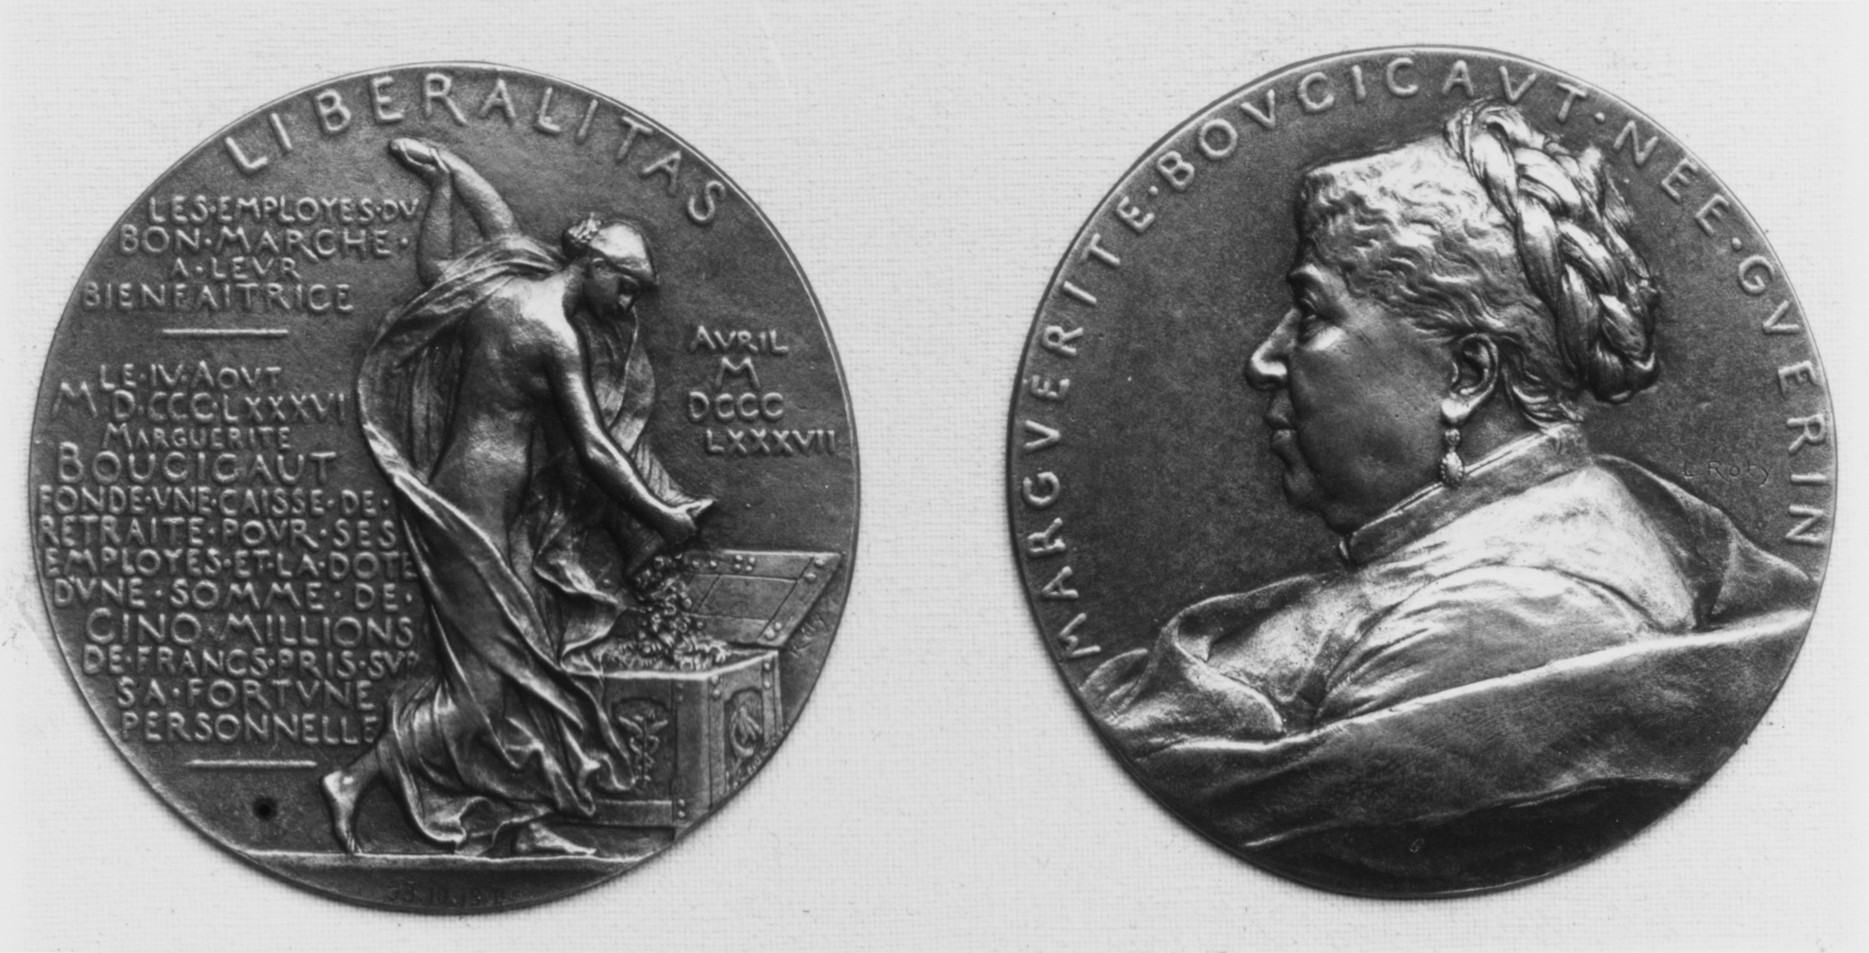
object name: medal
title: The Founding by Mme. Boucicaut of a Retiring Pension Fund for the Employees of the Bon Marché at Paris, 1886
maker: louis-oscar roty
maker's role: artist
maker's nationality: french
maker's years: 1846-1911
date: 1886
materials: bronze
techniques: casting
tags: profiles,women